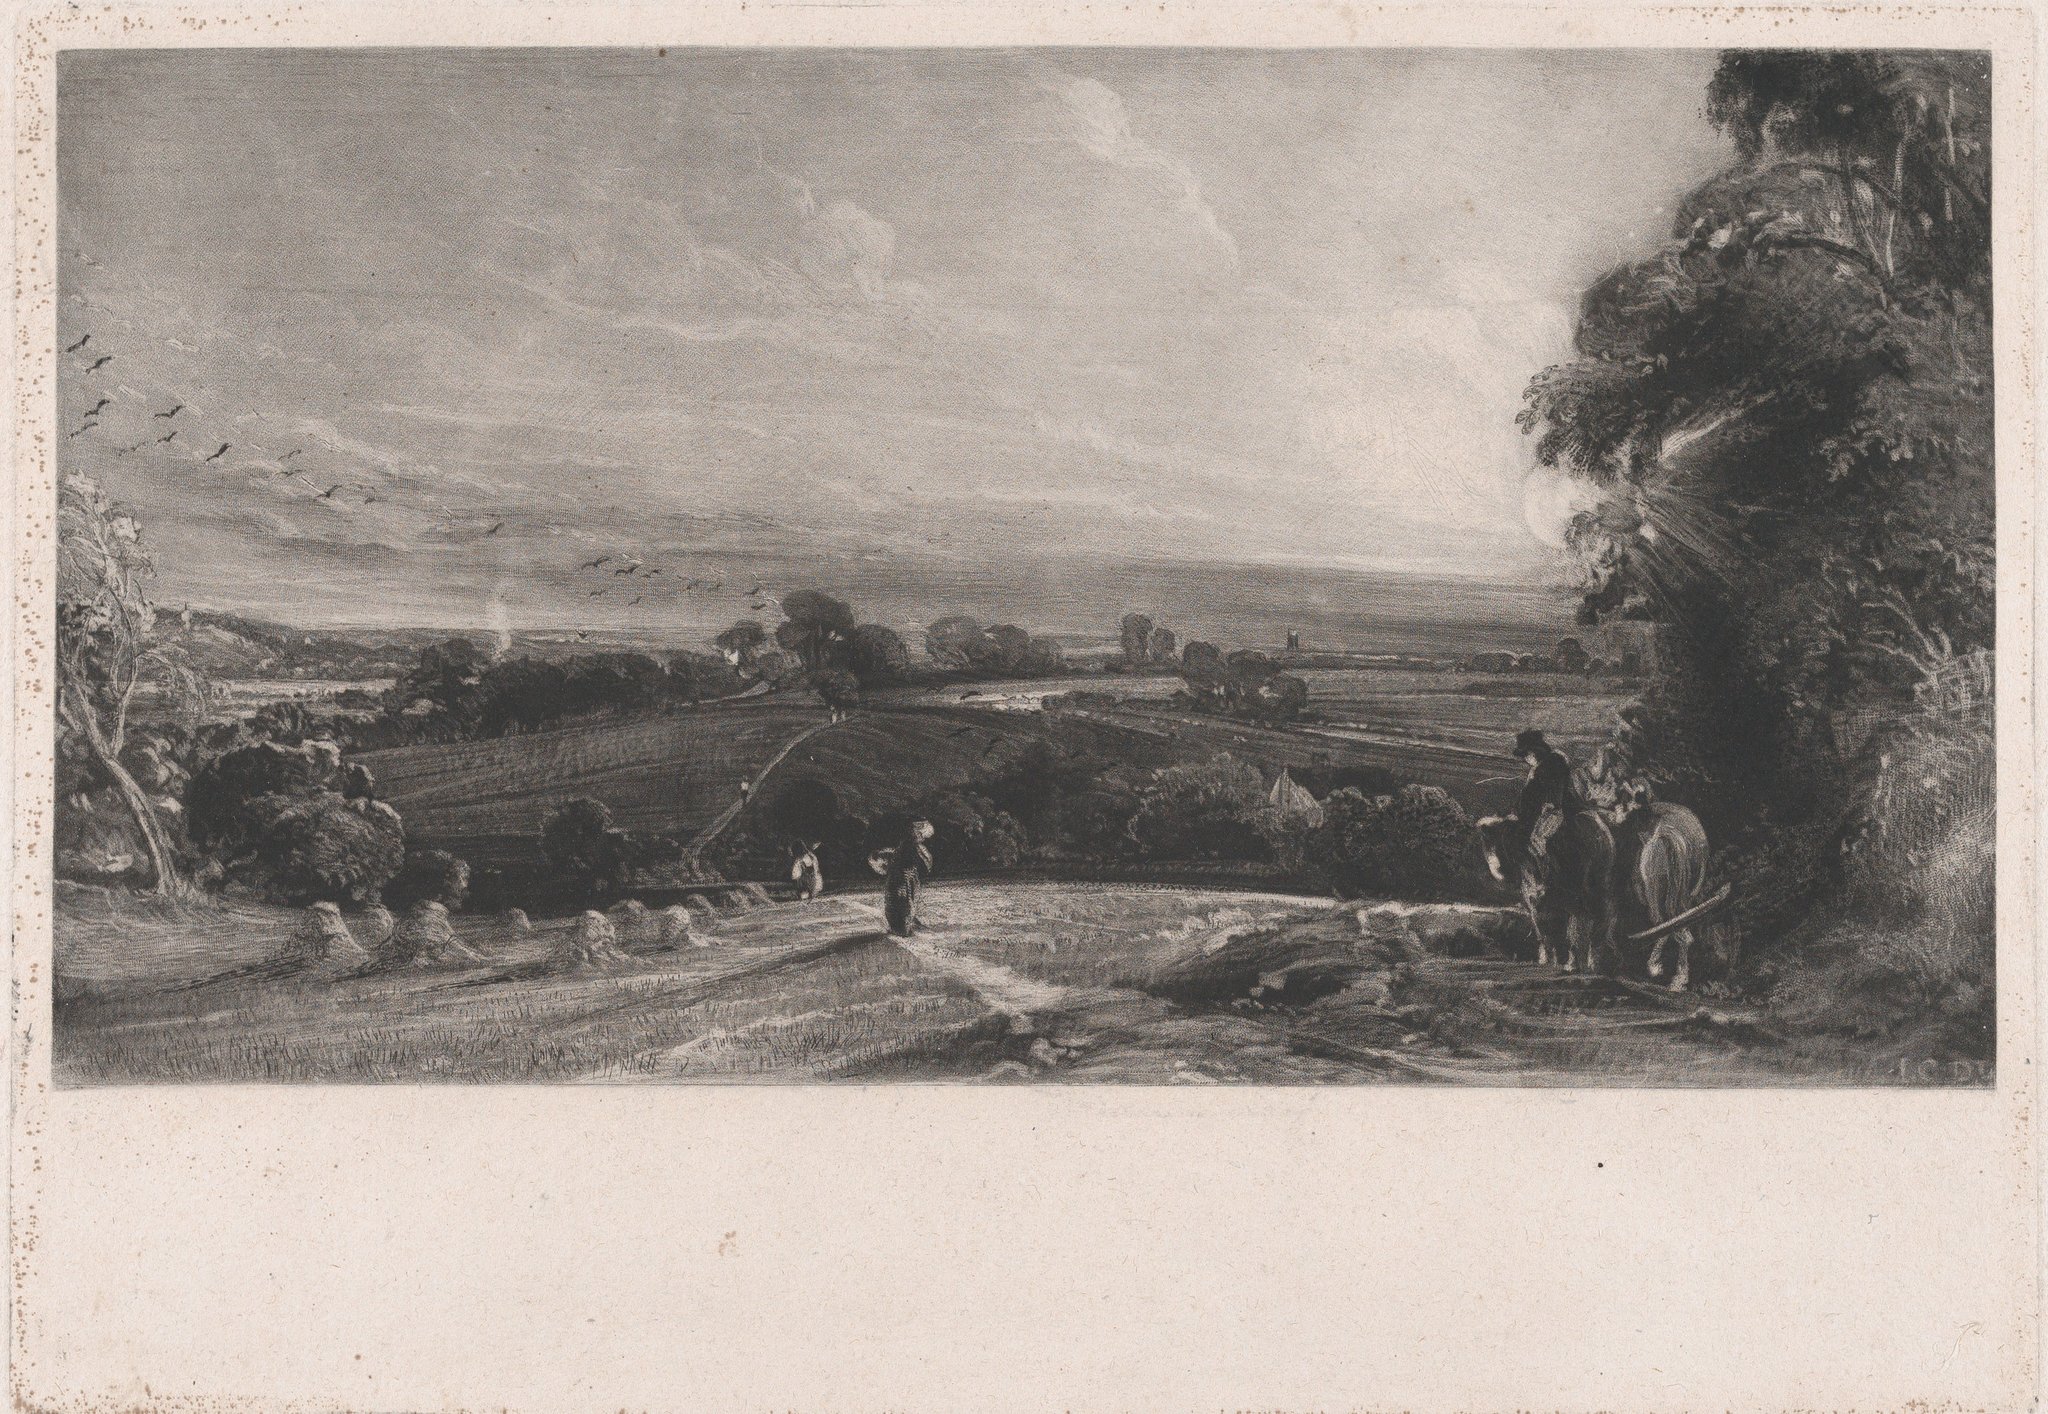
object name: print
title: Autumnal Sunset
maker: david lucas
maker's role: artist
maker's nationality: british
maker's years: 1802-1881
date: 1830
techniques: drypoint, mezzotint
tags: landscapes,autumn